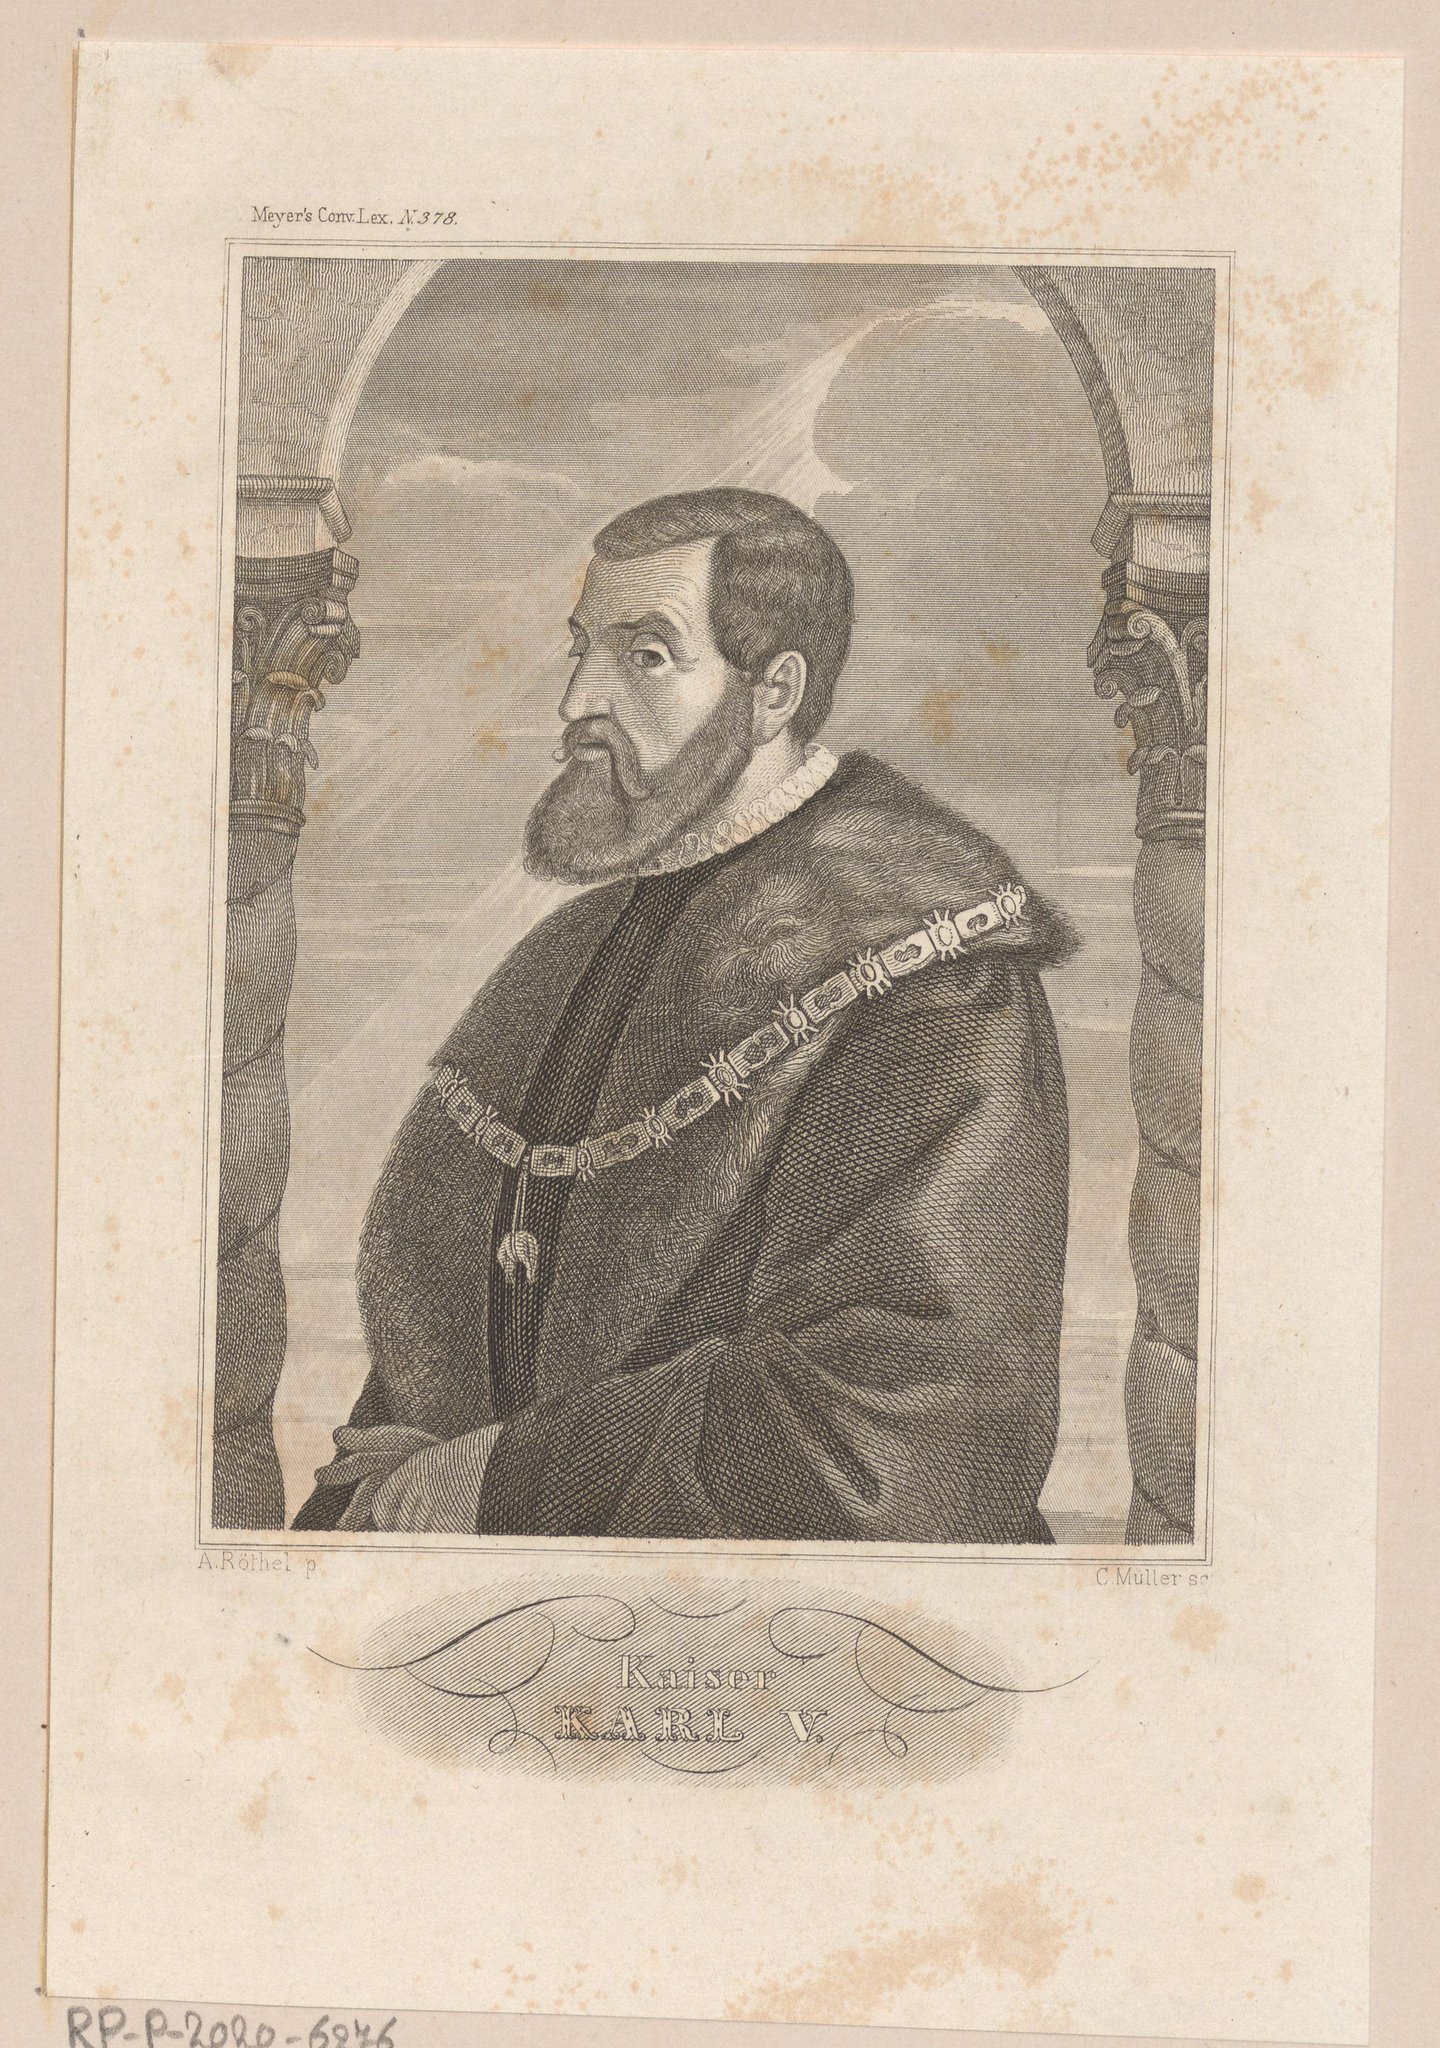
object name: print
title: Portret van keizer Karel V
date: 1839-1855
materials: paper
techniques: engraving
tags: charles v (holy roman emperor and king of spain), historical persons, knighthood order of the golden fleece, king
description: Prent mogelijk uit: Meyer, Joseph. Conversations-Lexikon für die gebildeten Stände. Hildburghausen: Bibliographisches Institut, 1839-1855.